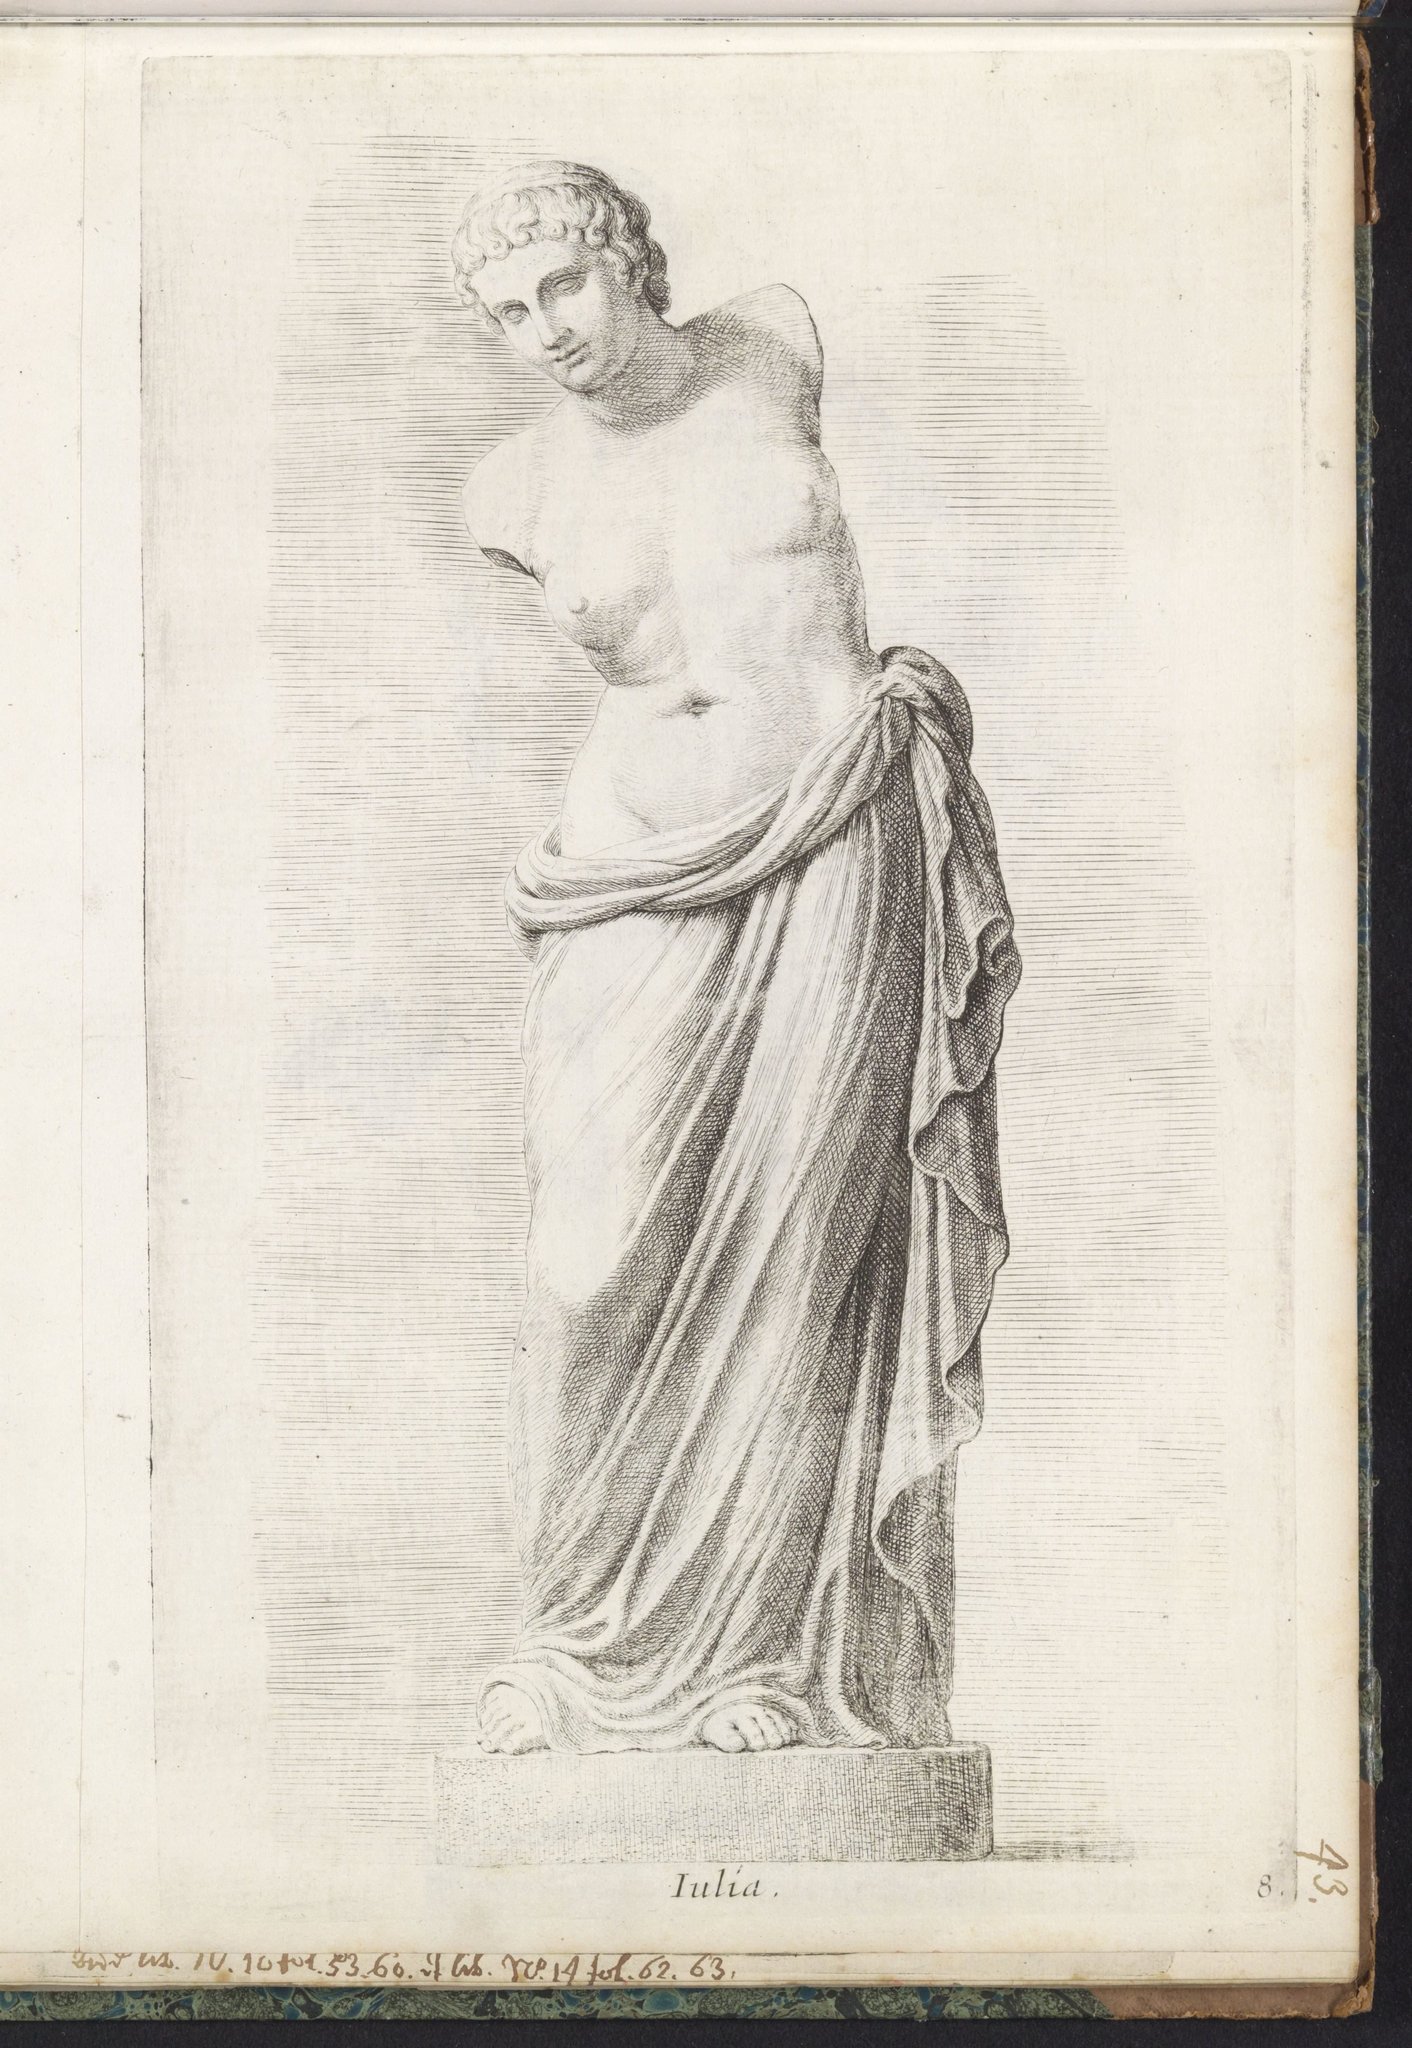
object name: album leaf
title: Sculptuur van Julia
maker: hubert quellinus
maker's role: print maker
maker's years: 1619-1687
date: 1646-1670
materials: paper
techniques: engraving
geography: antwerp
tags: piece of sculpture, reproduction of a piece of sculpture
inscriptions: number: ‘43’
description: Klassieke sculptuur van een staande vrouw met gedrapeerde rok, zonder armen. De prent maakt deel uit van een album met een serie prenten naar de sculpturen in de verzameling van Gerard Reynst.